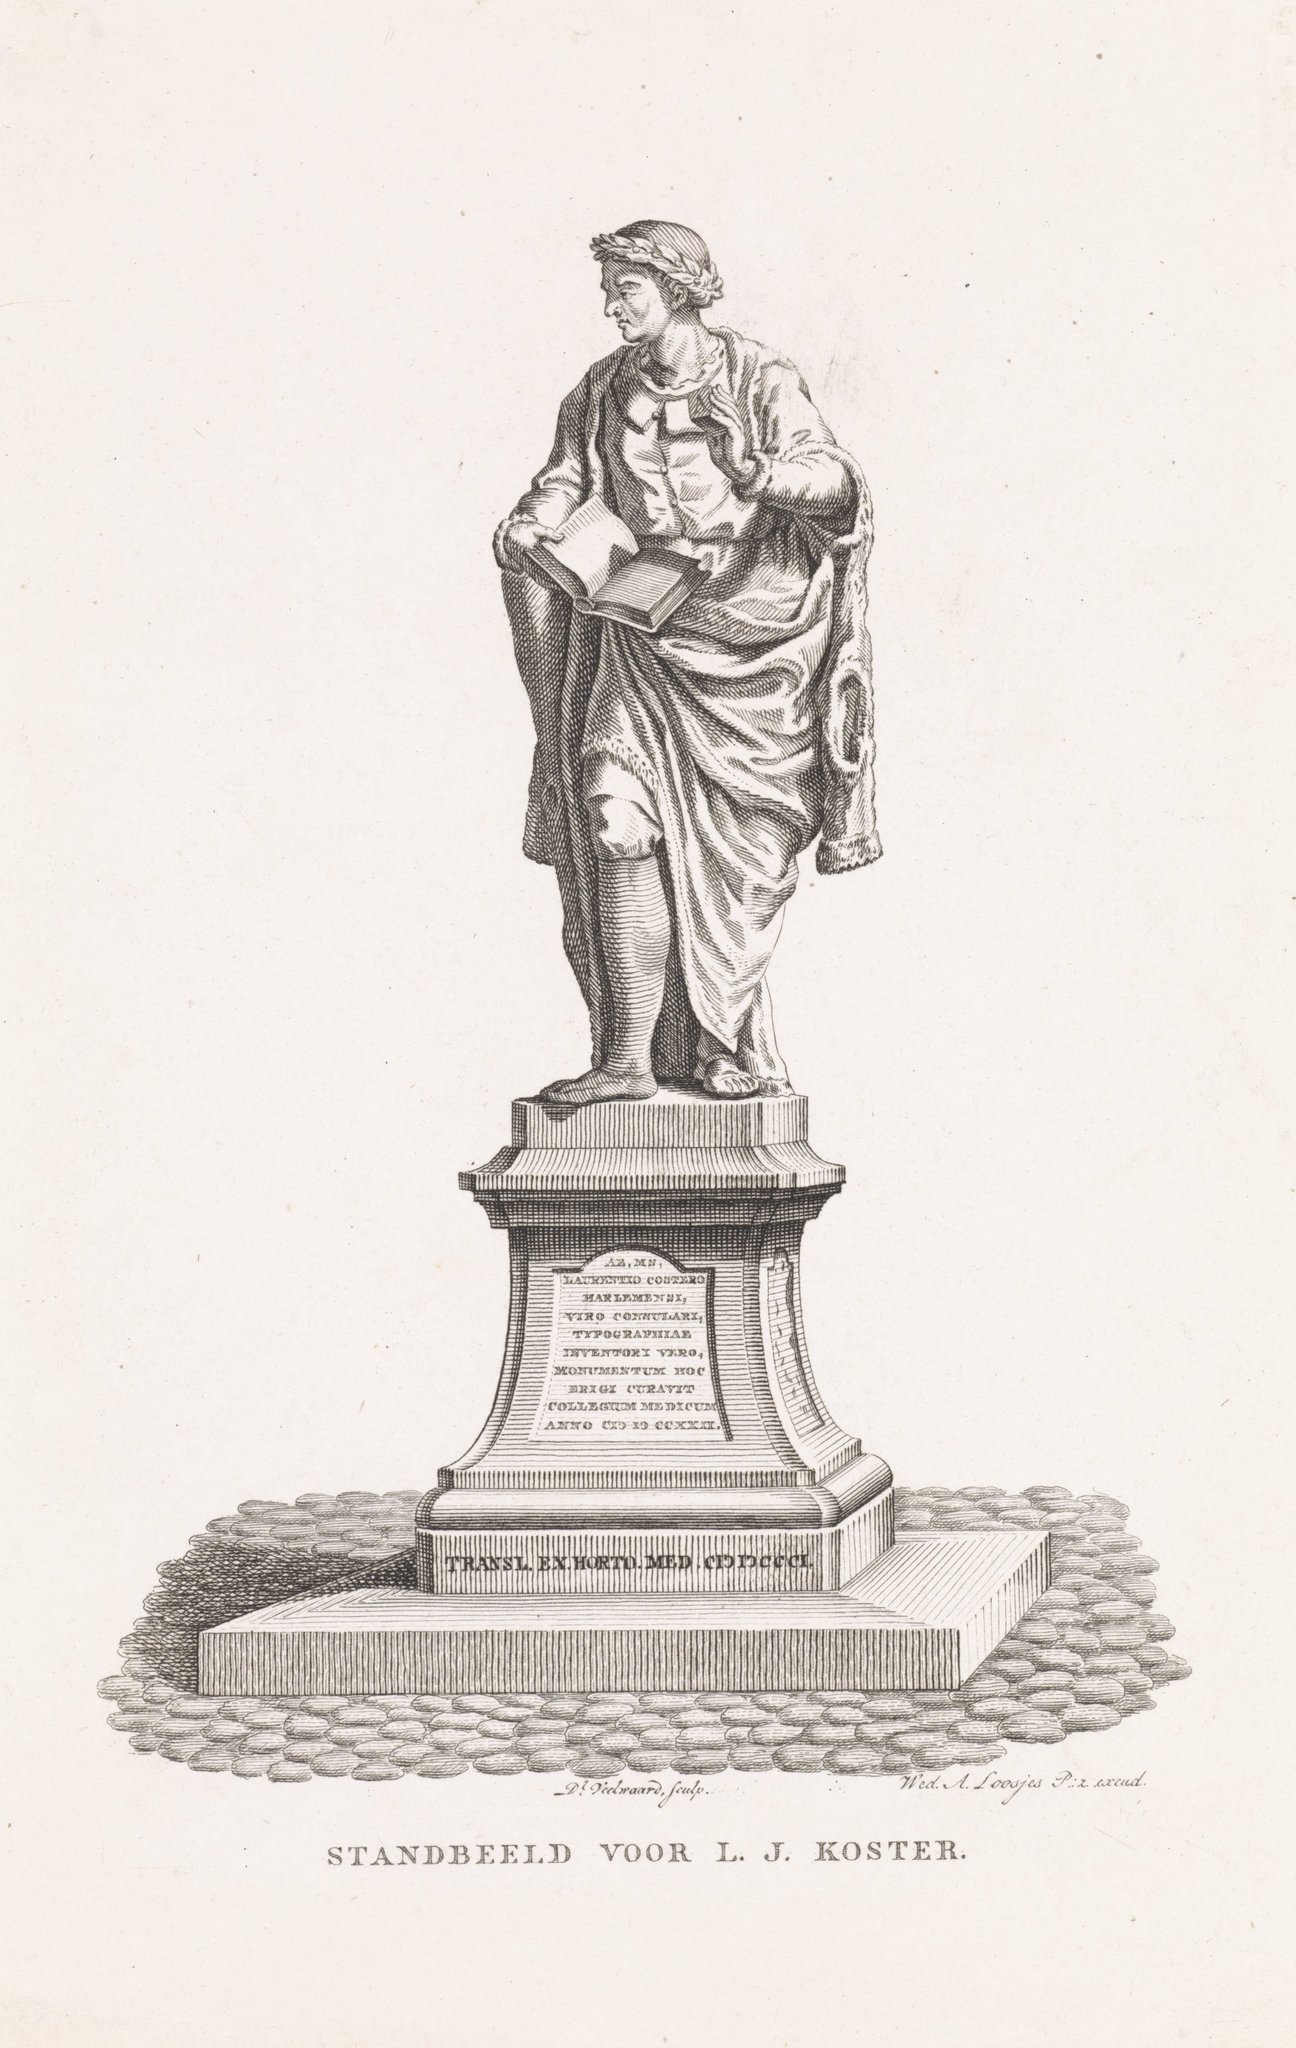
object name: print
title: Standbeeld van Laurens Jansz. Coster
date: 1801-1851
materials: paper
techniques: engraving, etching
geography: haarlem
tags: haarlem, monument, statue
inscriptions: collector's mark: Lugt 2228